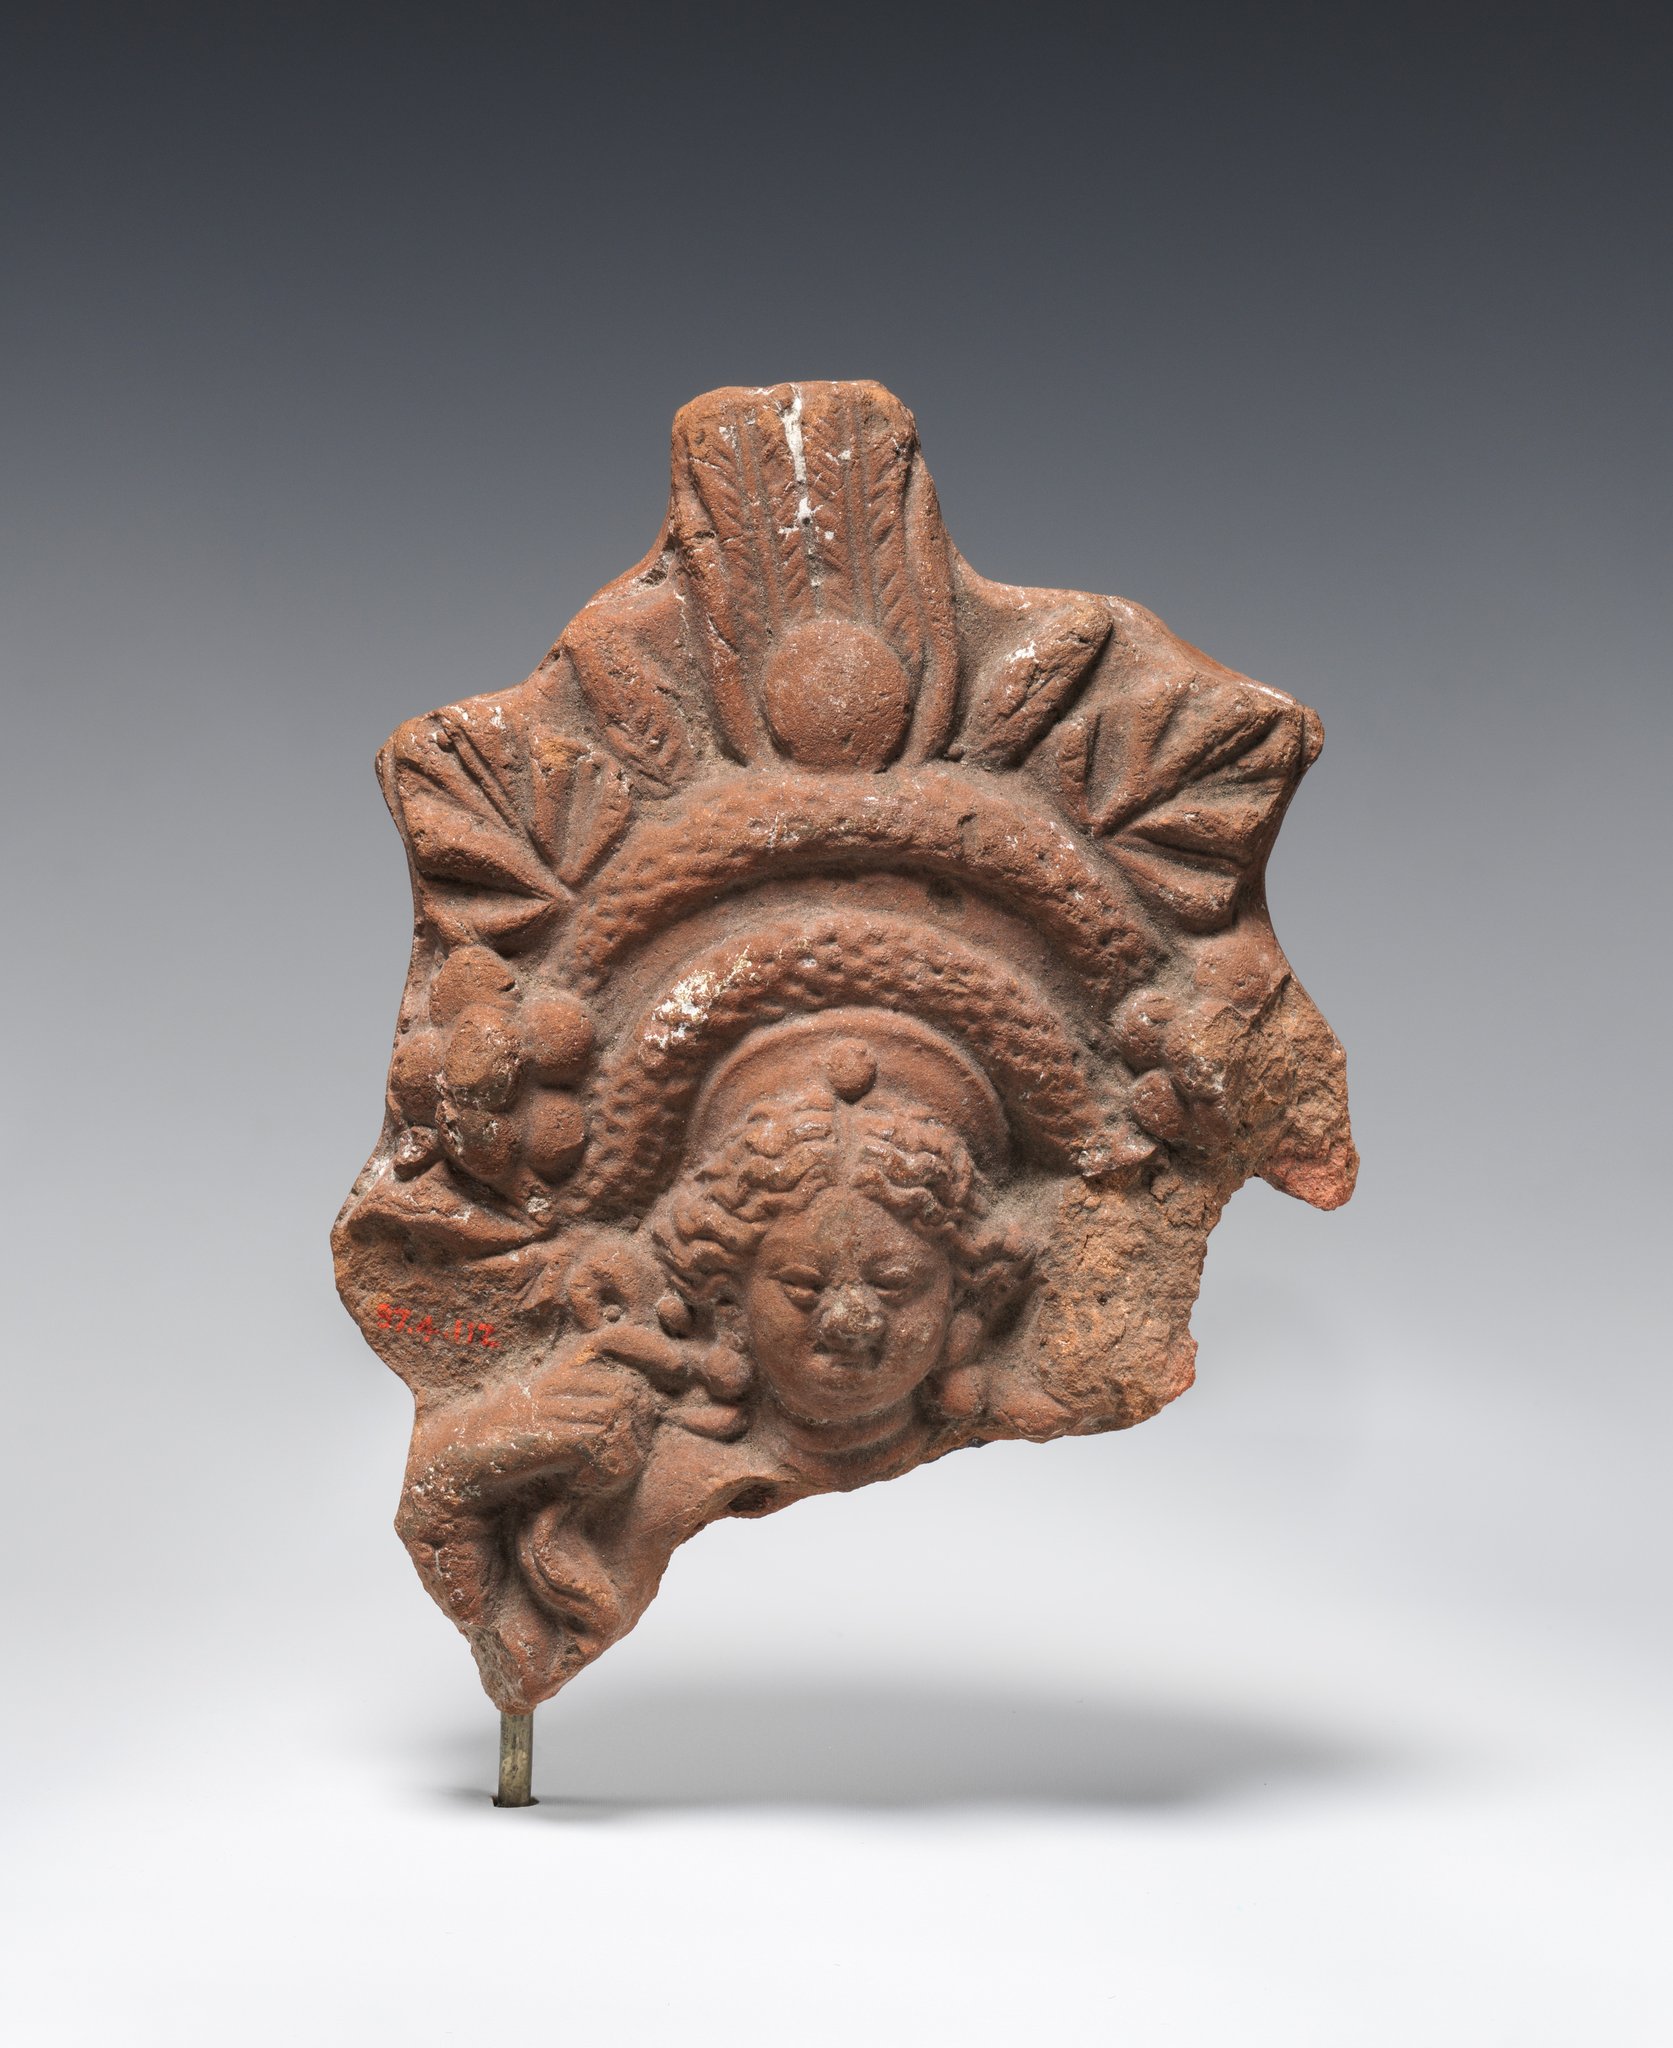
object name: statuette fragment, head, headdress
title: Figurine with elaborate headdress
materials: terracotta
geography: egypt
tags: women